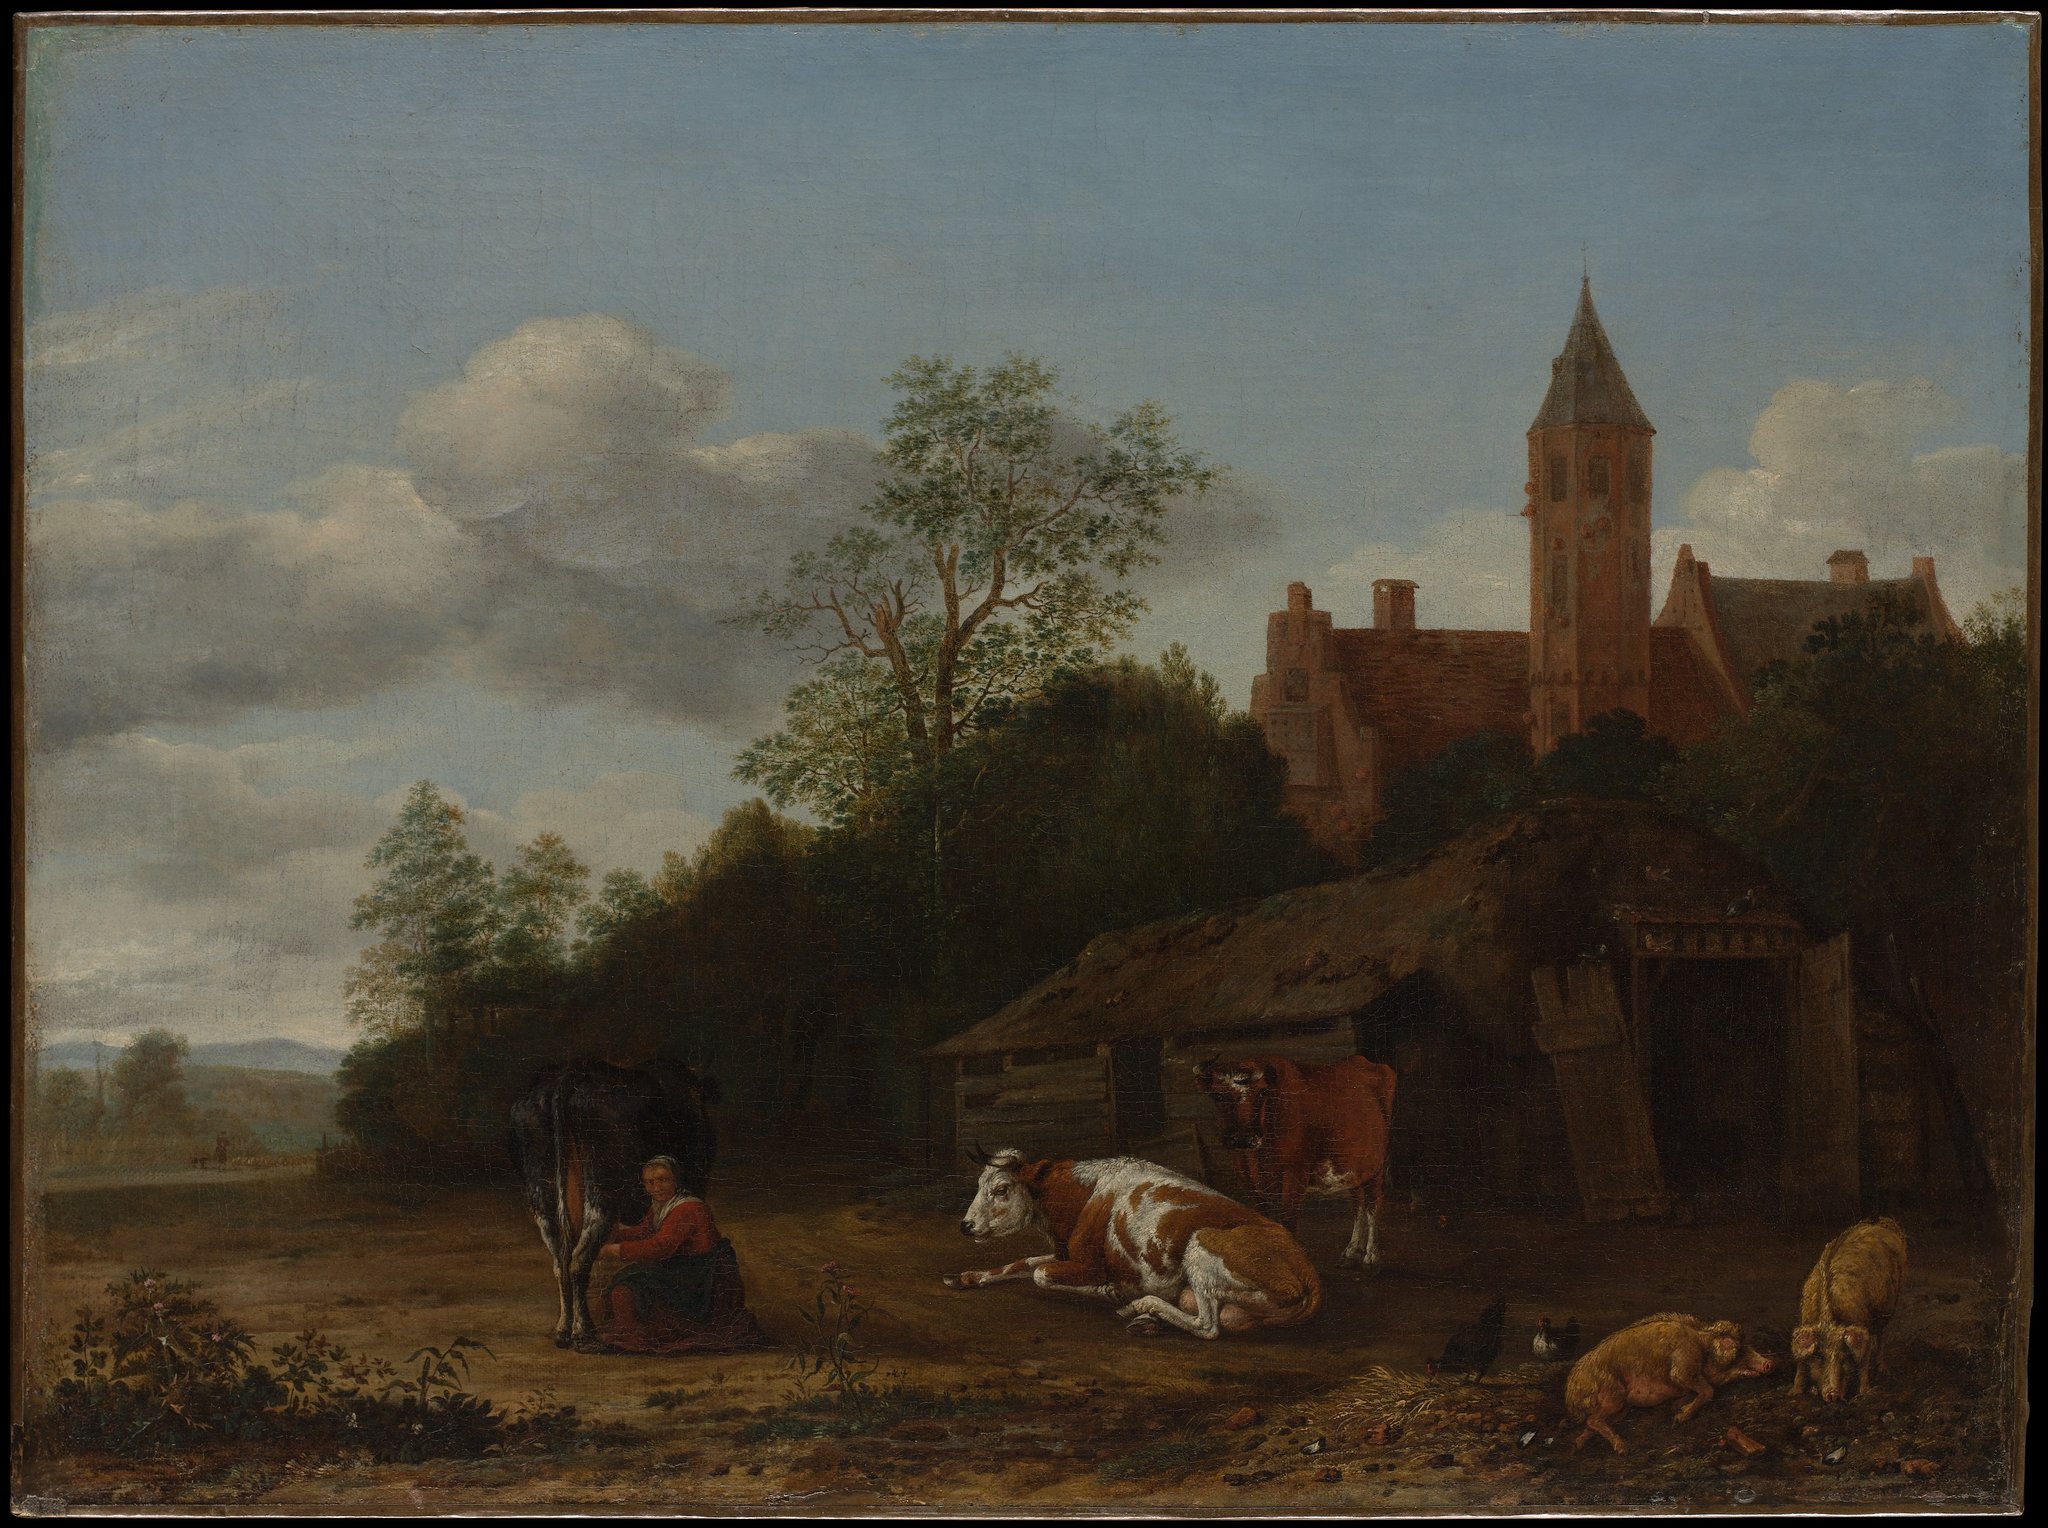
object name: painting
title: Barnyard Scene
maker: anthonie van borssom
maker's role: artist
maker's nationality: dutch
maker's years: 1631-1677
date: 1650-1655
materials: canvas, oil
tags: women,cows,pigs,sheep